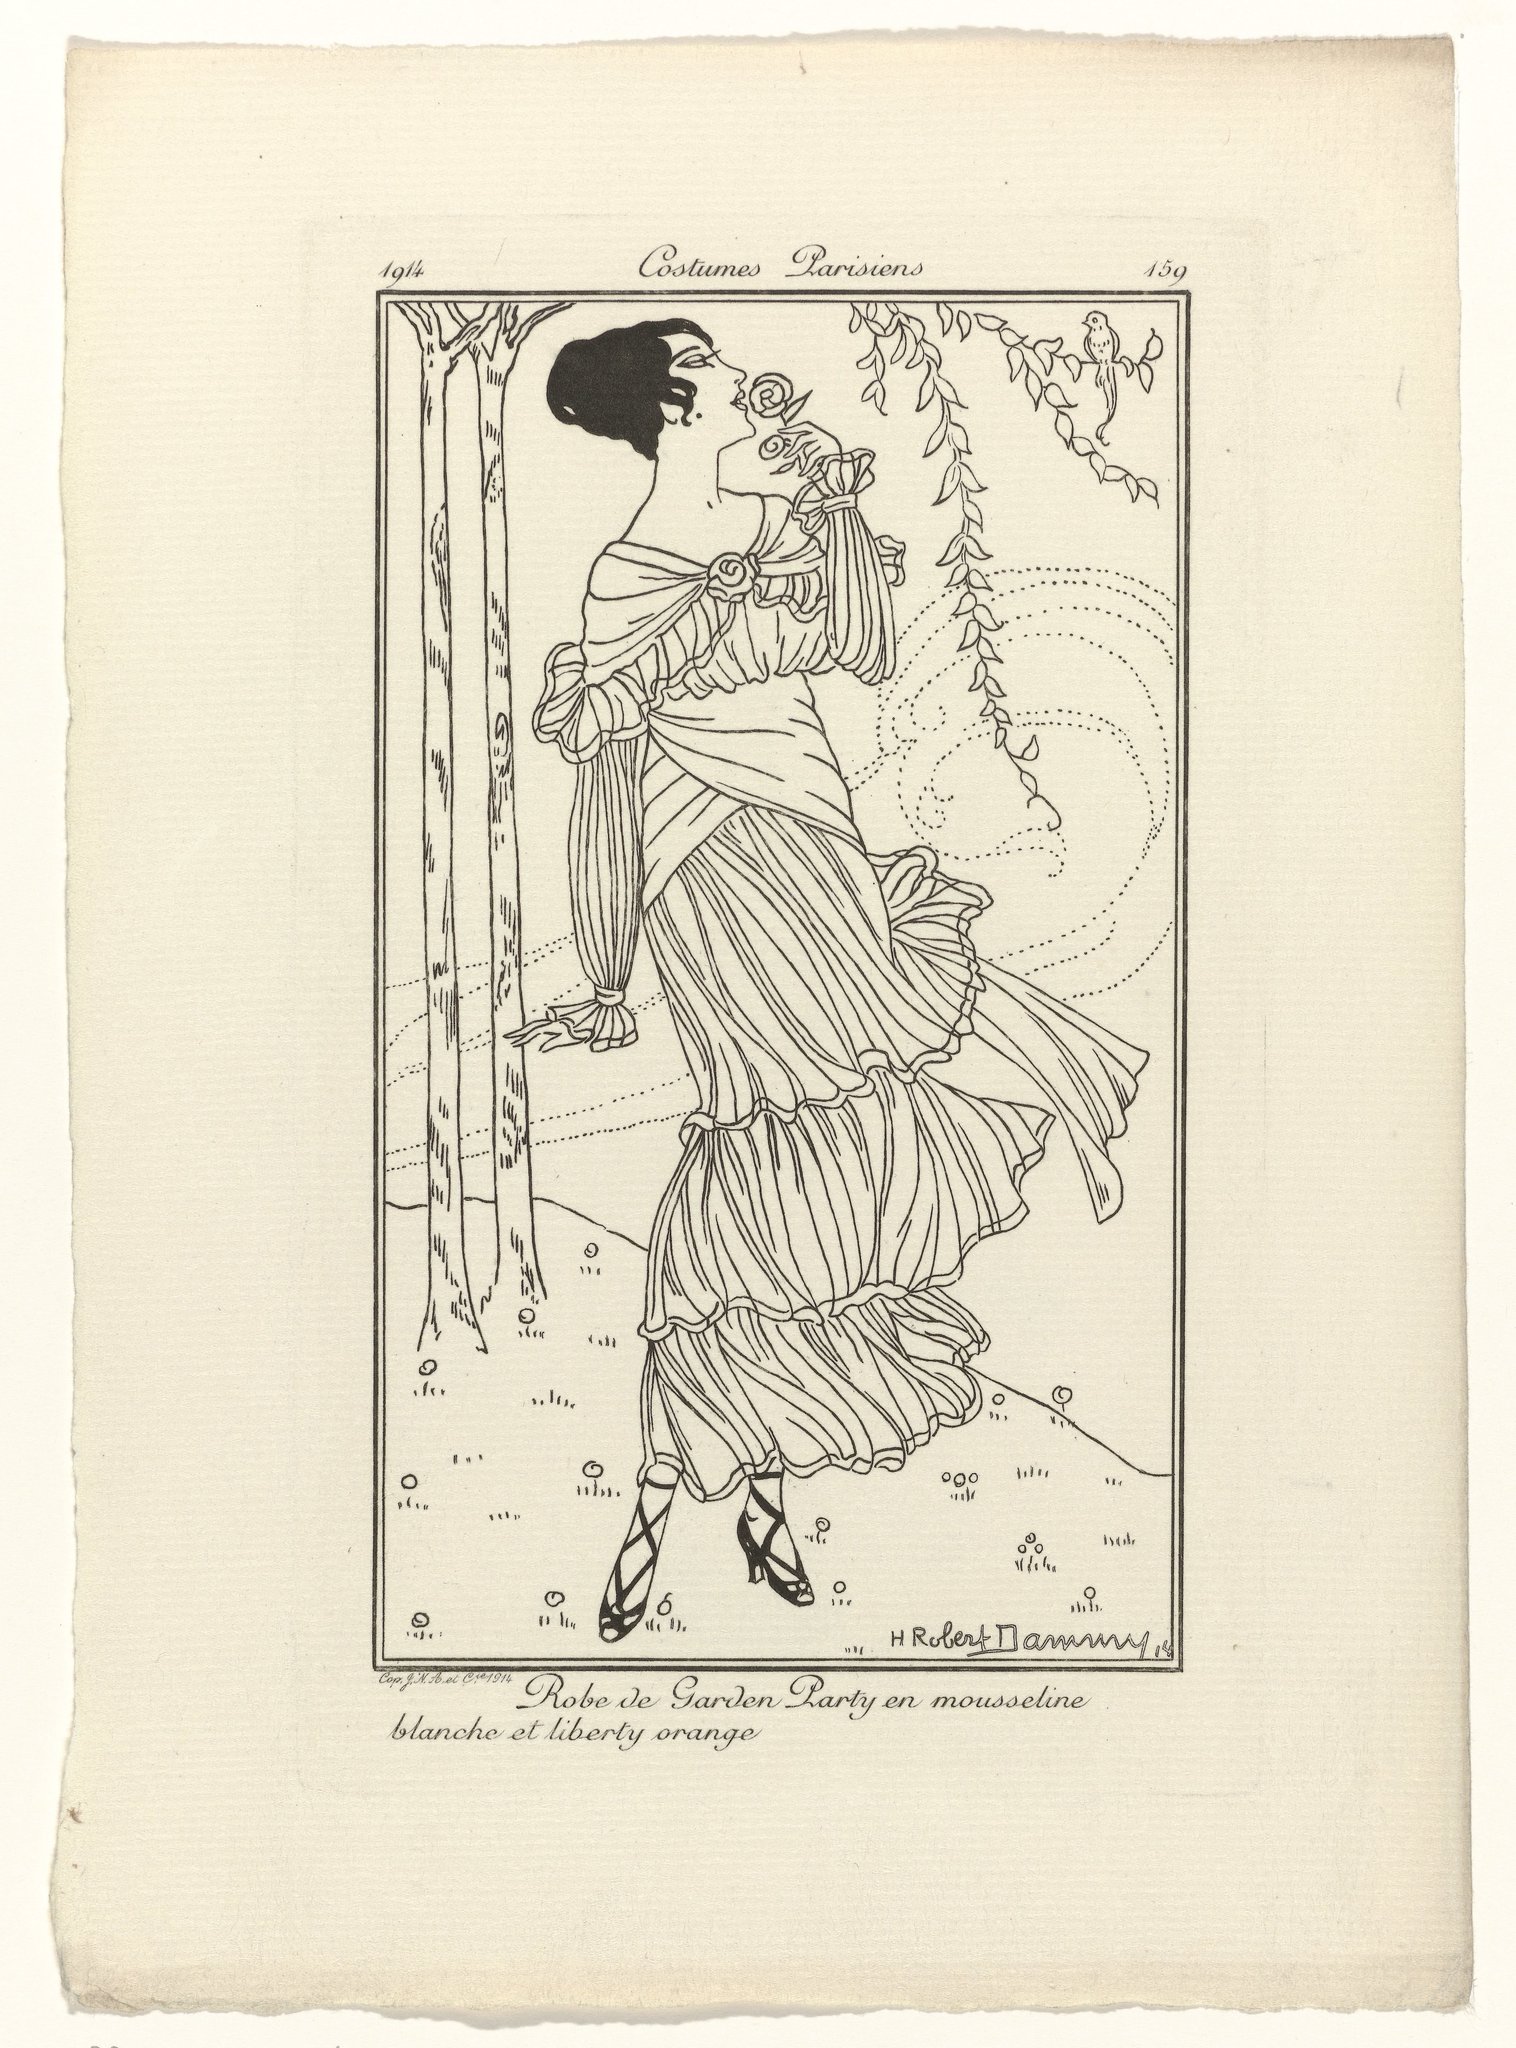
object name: fashion print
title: Journal des Dames et des Modes, Costumes Parisiens, 1914, No. 159 : Robe de Garden Party (...)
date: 1914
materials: paper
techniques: engraving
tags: flowers, birds, fashion plates, dress, gown (+ women's clothes), smell, smelling (one of the five senses) - aa - female human figure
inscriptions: title: ‘Costumes Parisiens’, caption: ‘Robe de Garden Party en mousseline blanche et liberty orange.’, inscription: ‘Cop. J. N. A. et Cie 1914’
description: Japon voor een tuinfeest van witte mousseline en oranje 'liberty'. Pumps met gekruiste banden. Proefdruk van een prent uit het modetijdschrift Journal des Dames et des Modes (1912-1914).